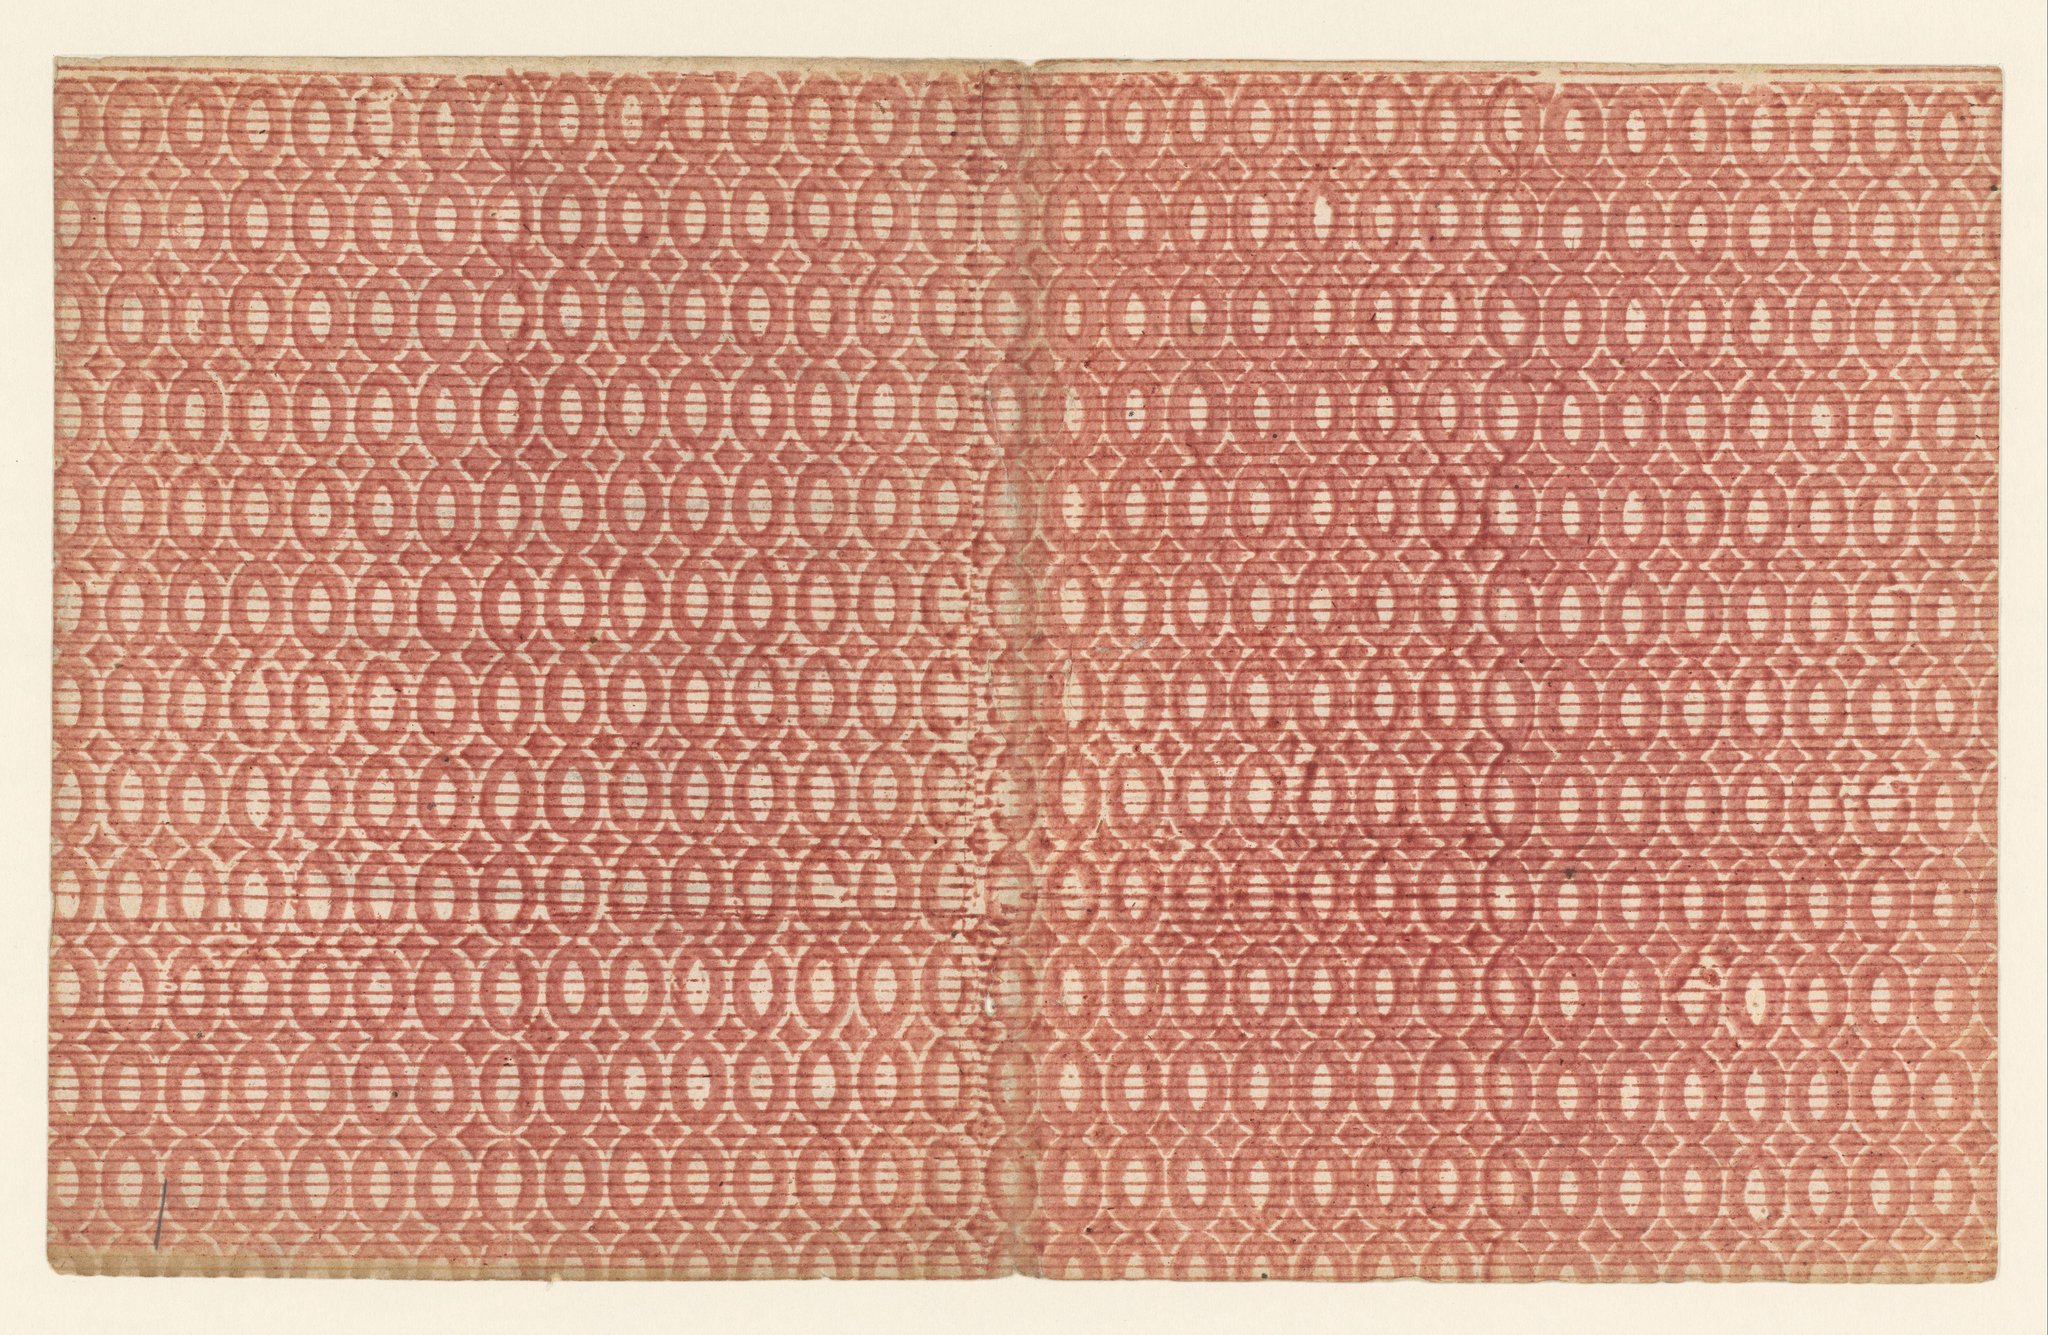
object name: printed paper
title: Blad met banenpatroon van ovaal motief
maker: Anonymous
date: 1700-1850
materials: paper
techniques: printing block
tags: ornament ~ geometric motifs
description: Blad met banenpatroon van een ovaal motief onder een doorlopend horizontaal lijnenfond. Gebruikt als omslag.